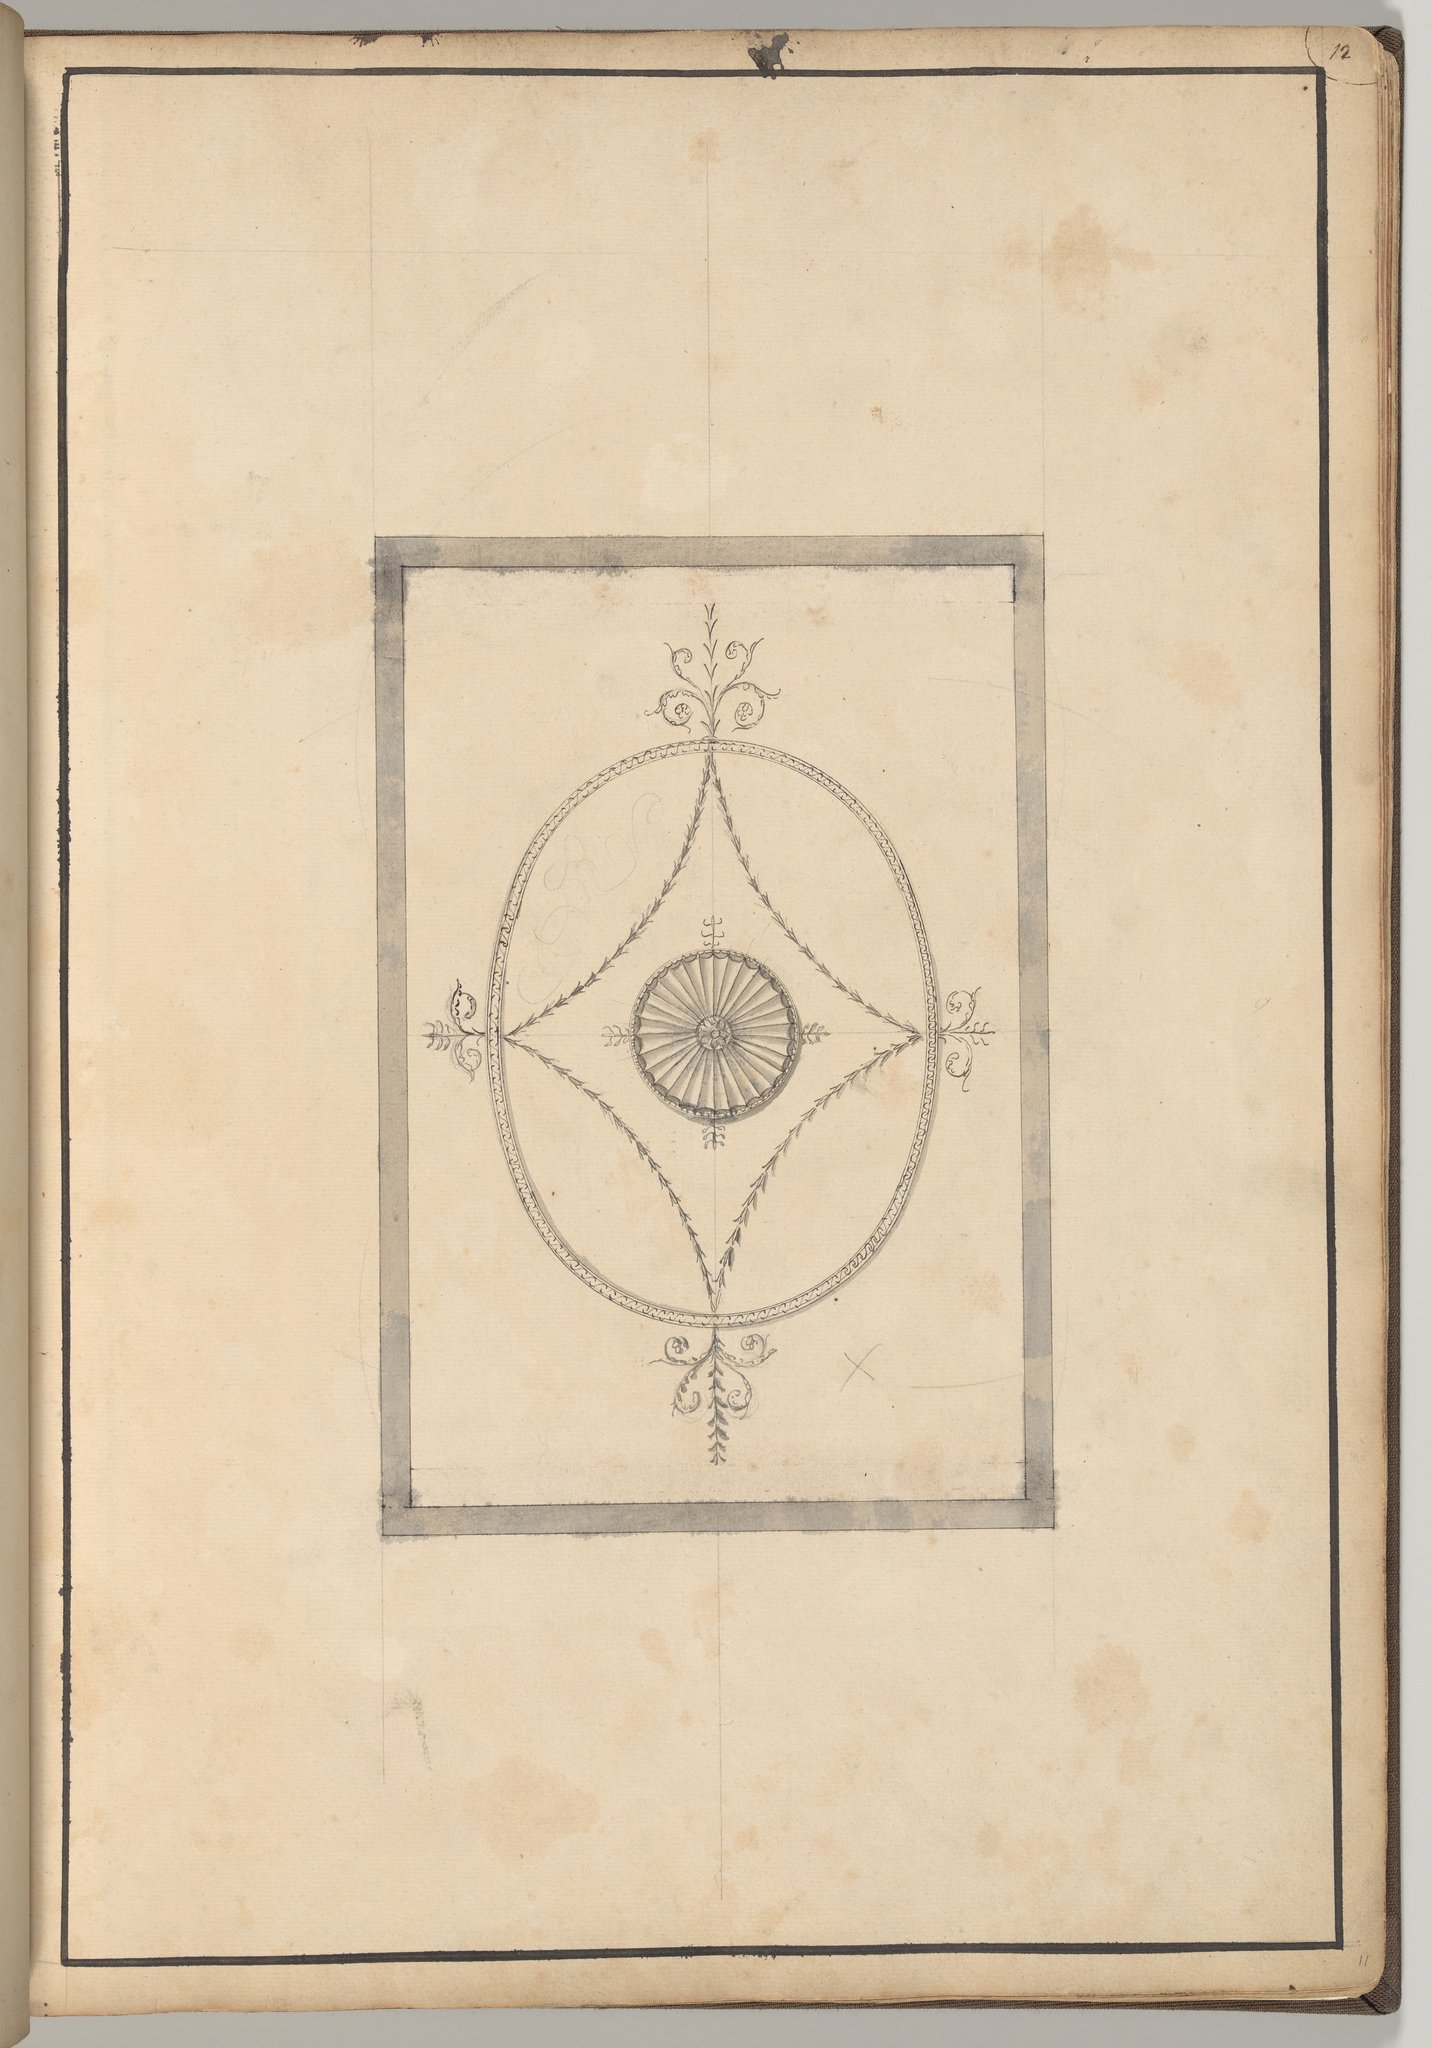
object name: drawing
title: Design for the Ceiling of a Bedchamber at Curraghmore, County Waterford, Ireland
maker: james wyatt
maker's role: artist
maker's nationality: british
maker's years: 1746-1813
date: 1786-1787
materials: graphite, ink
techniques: brush, pen, wash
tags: ceilings